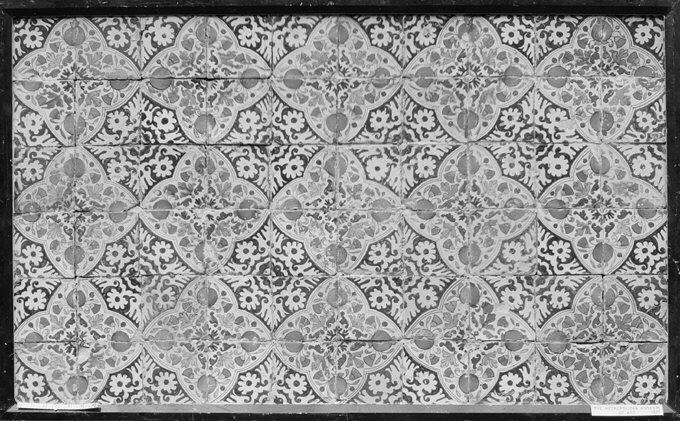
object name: tile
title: Tiles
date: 1601-1625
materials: earthenware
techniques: glazing